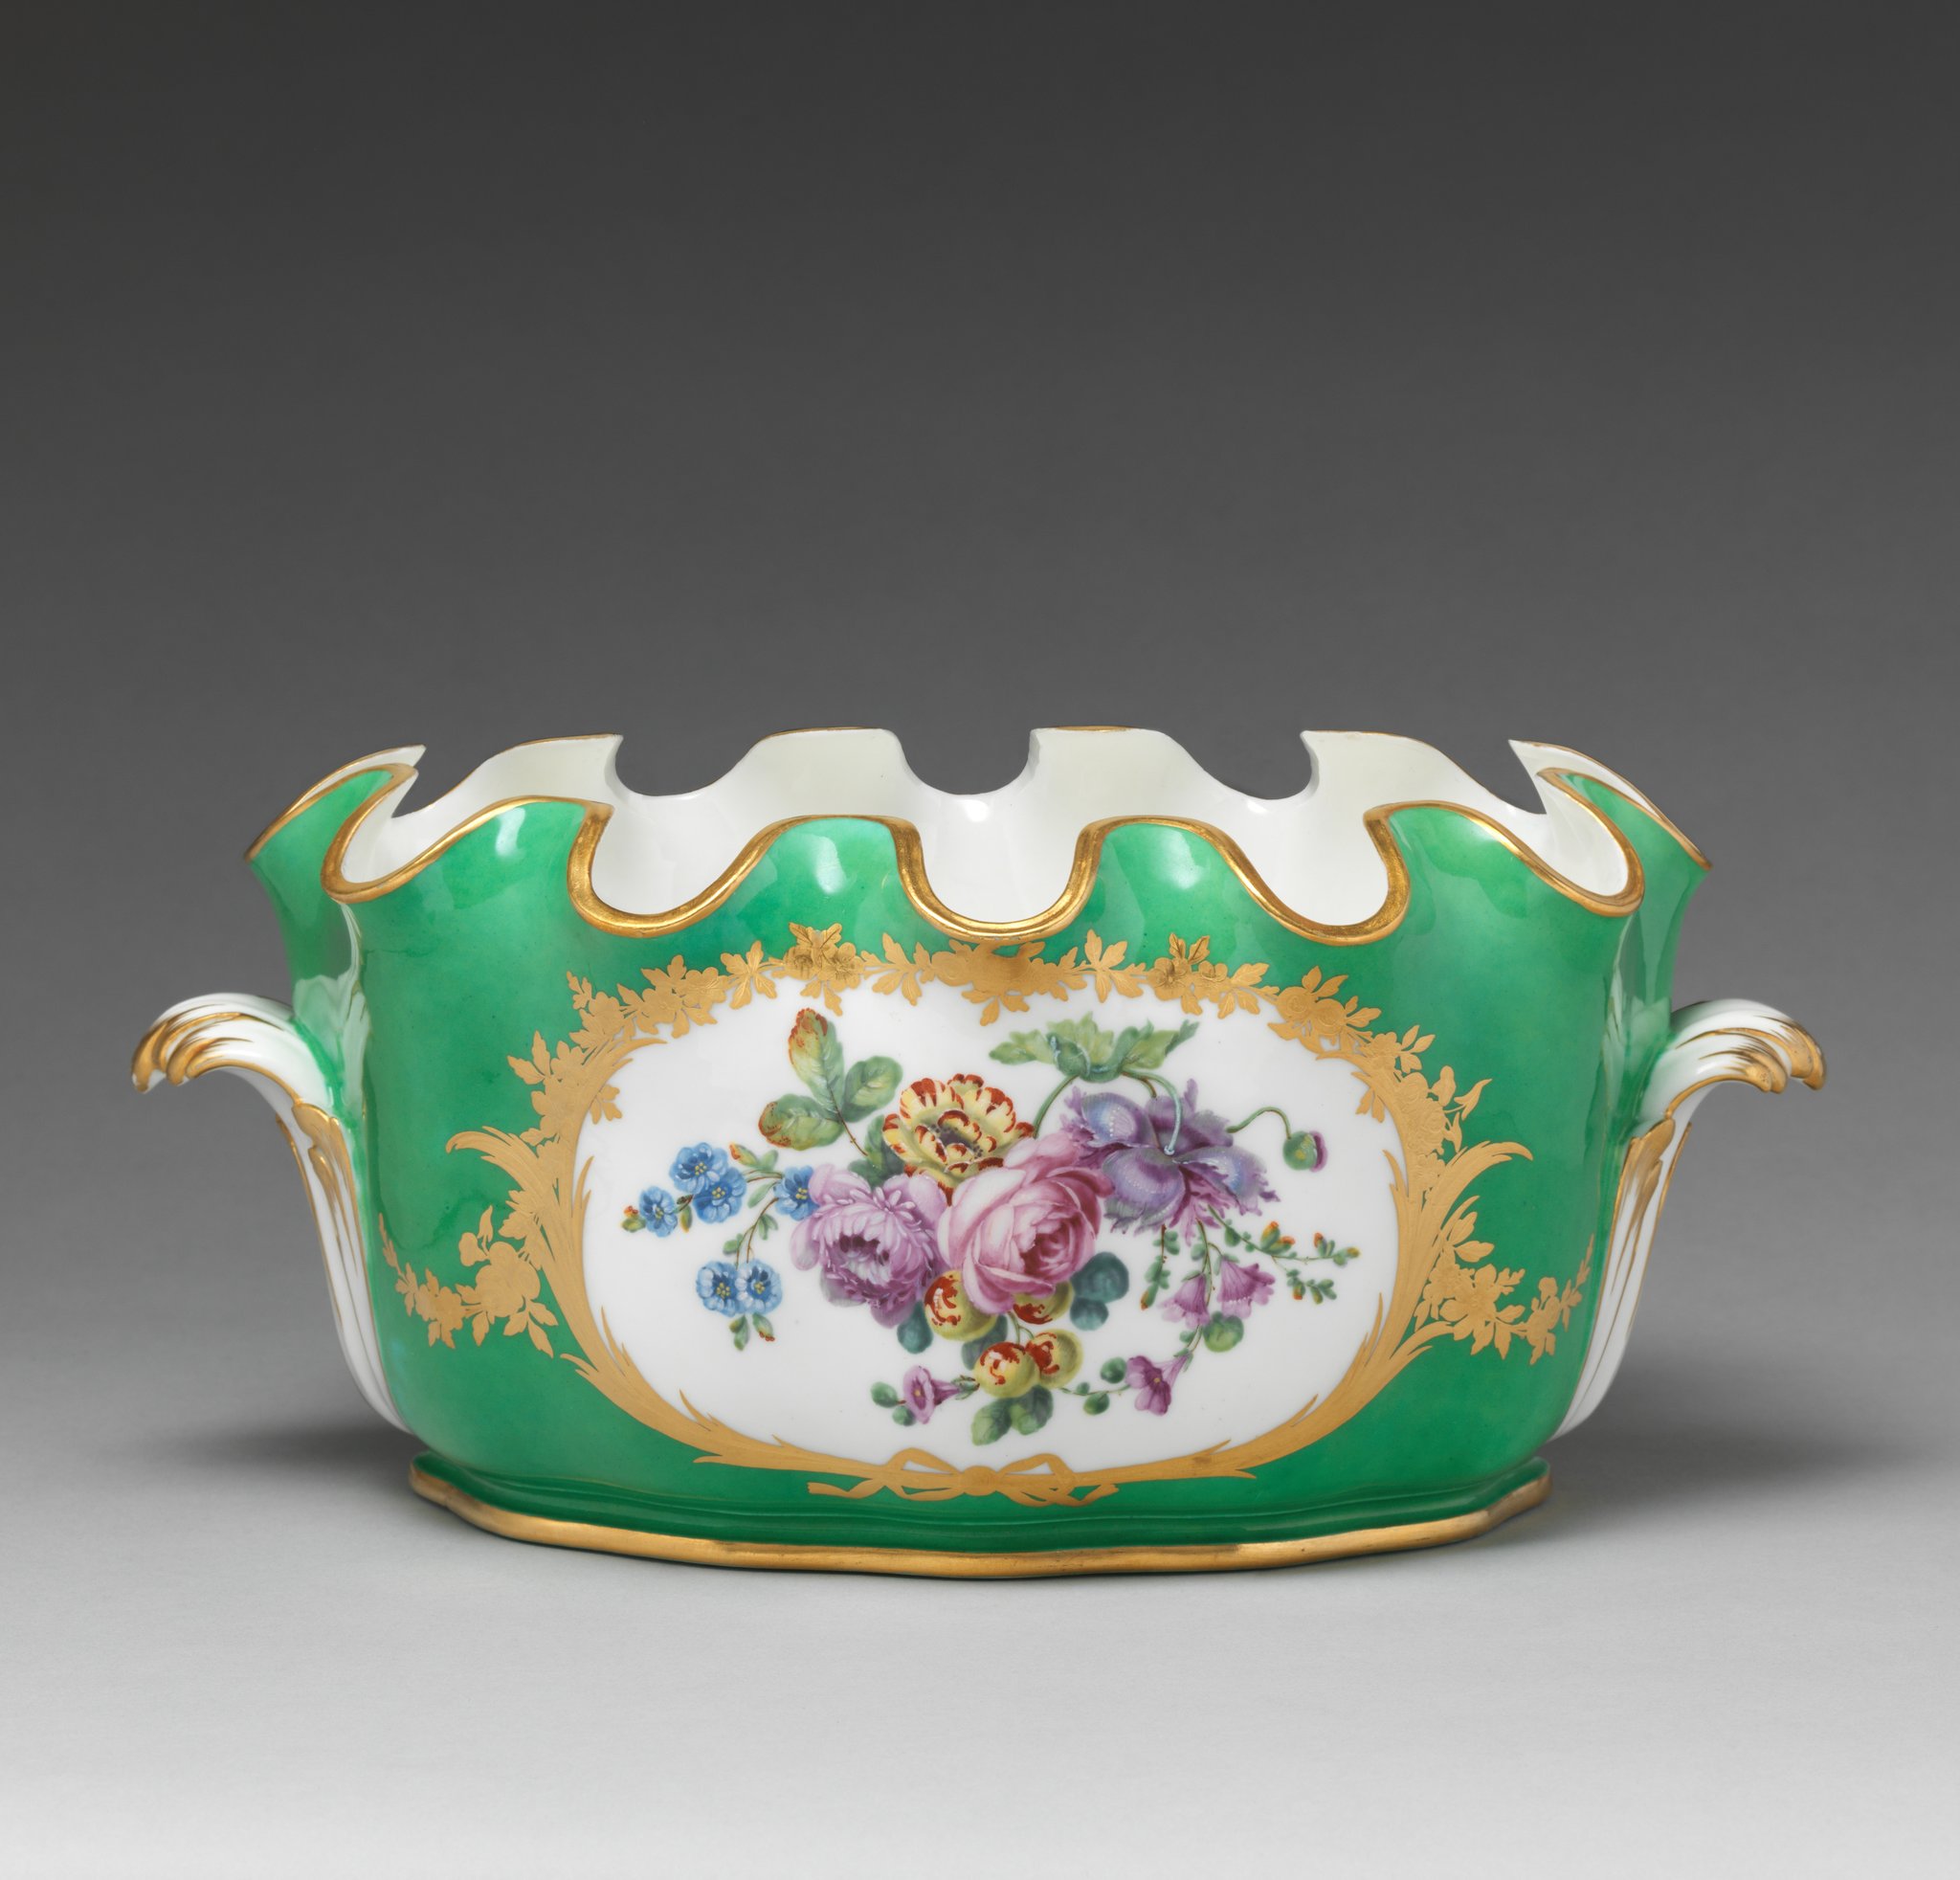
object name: monteith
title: Monteith (Seau crennelé) (part of a service)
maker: sèvres manufactory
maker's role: manufactory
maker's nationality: french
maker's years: 1740-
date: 1771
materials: soft paste porcelain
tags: flowers